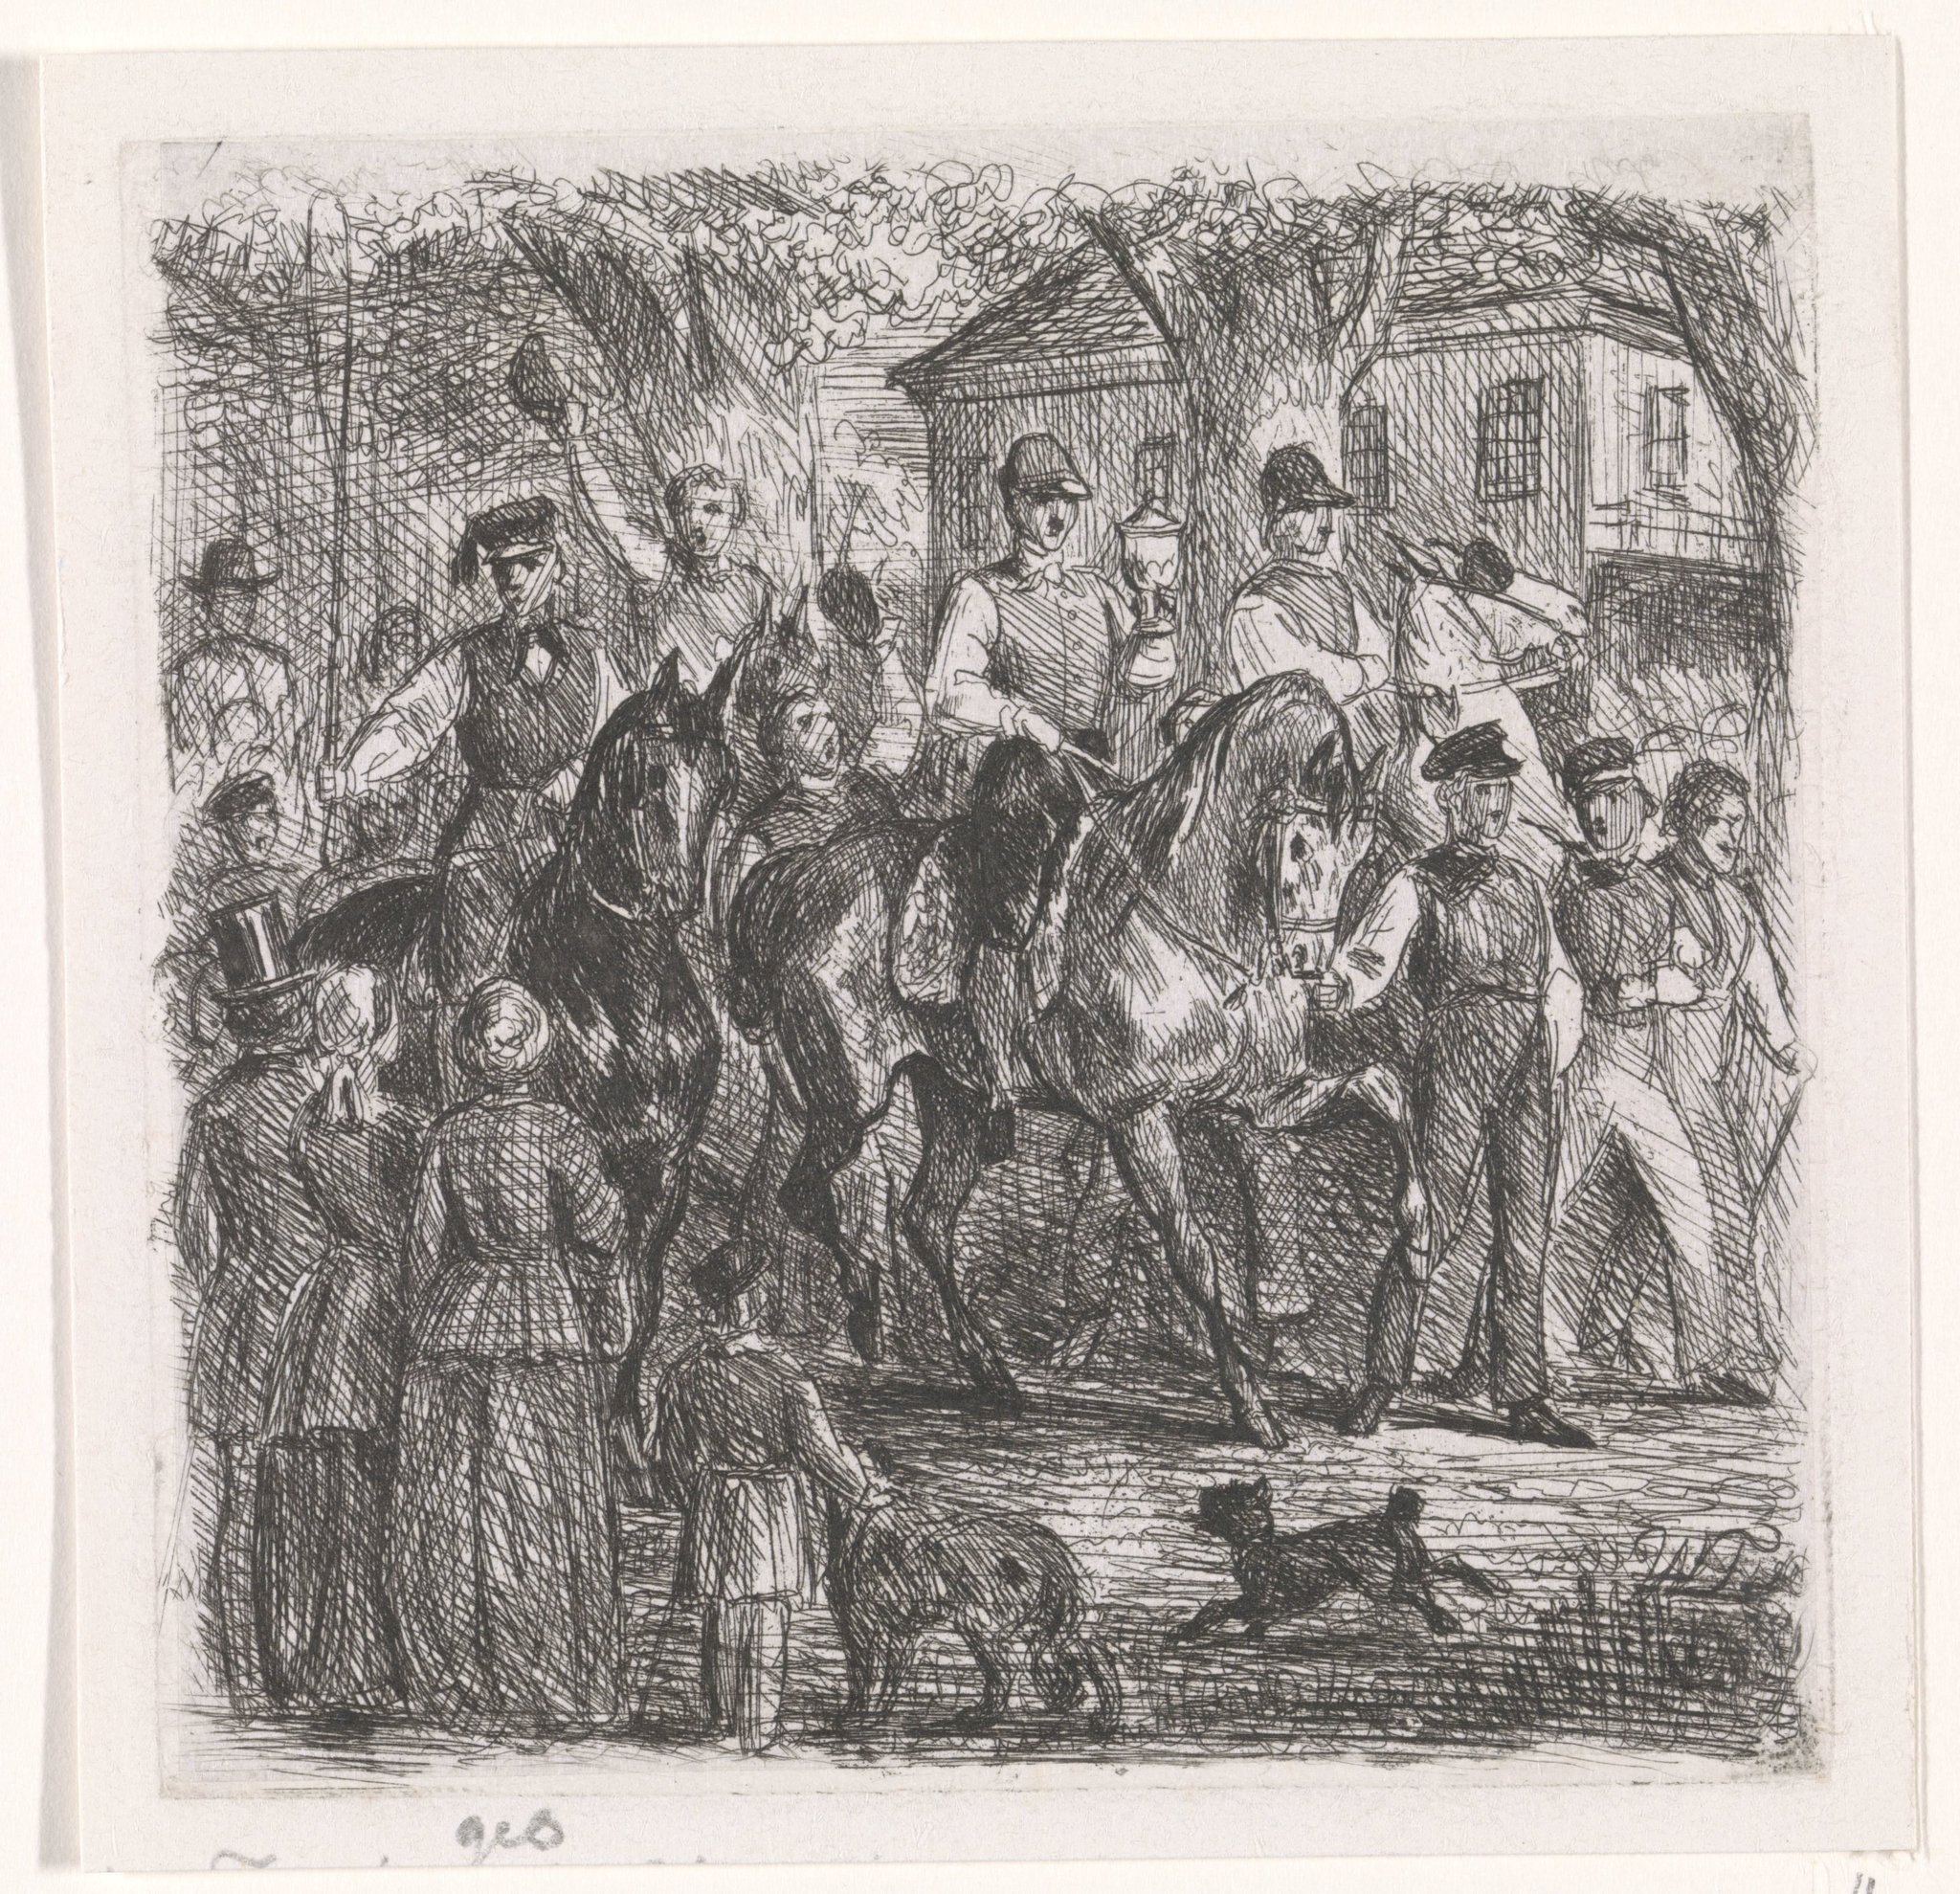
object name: print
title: Intocht van de winnaars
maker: willem de famars testas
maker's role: draughtsman, painter, print maker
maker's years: 1834-1896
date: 1844-1896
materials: paper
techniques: etching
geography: netherlands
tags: trophy, i.e.: decorative arrangement of symbolic or typical objects ~ ornament, rejoicing on special occasions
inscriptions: collector's mark: Lugt 2228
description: Intocht van winnaars te paard. Een van hen houdt een trofee in de hand. Zij worden ontvangen door mensen die langs de weg toekijken.